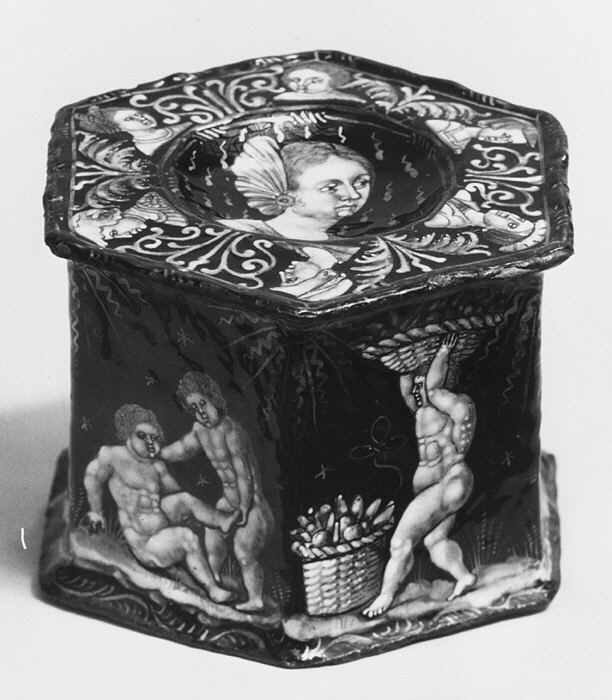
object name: saltcellar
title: Saltcellar with scene of infant harvesters (one of a pair)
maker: pierre reymond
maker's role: enameler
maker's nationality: french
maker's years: 1513-1590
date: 1540-1545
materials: copper, enamel, gilt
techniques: painting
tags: faces,infants,male nudes,working